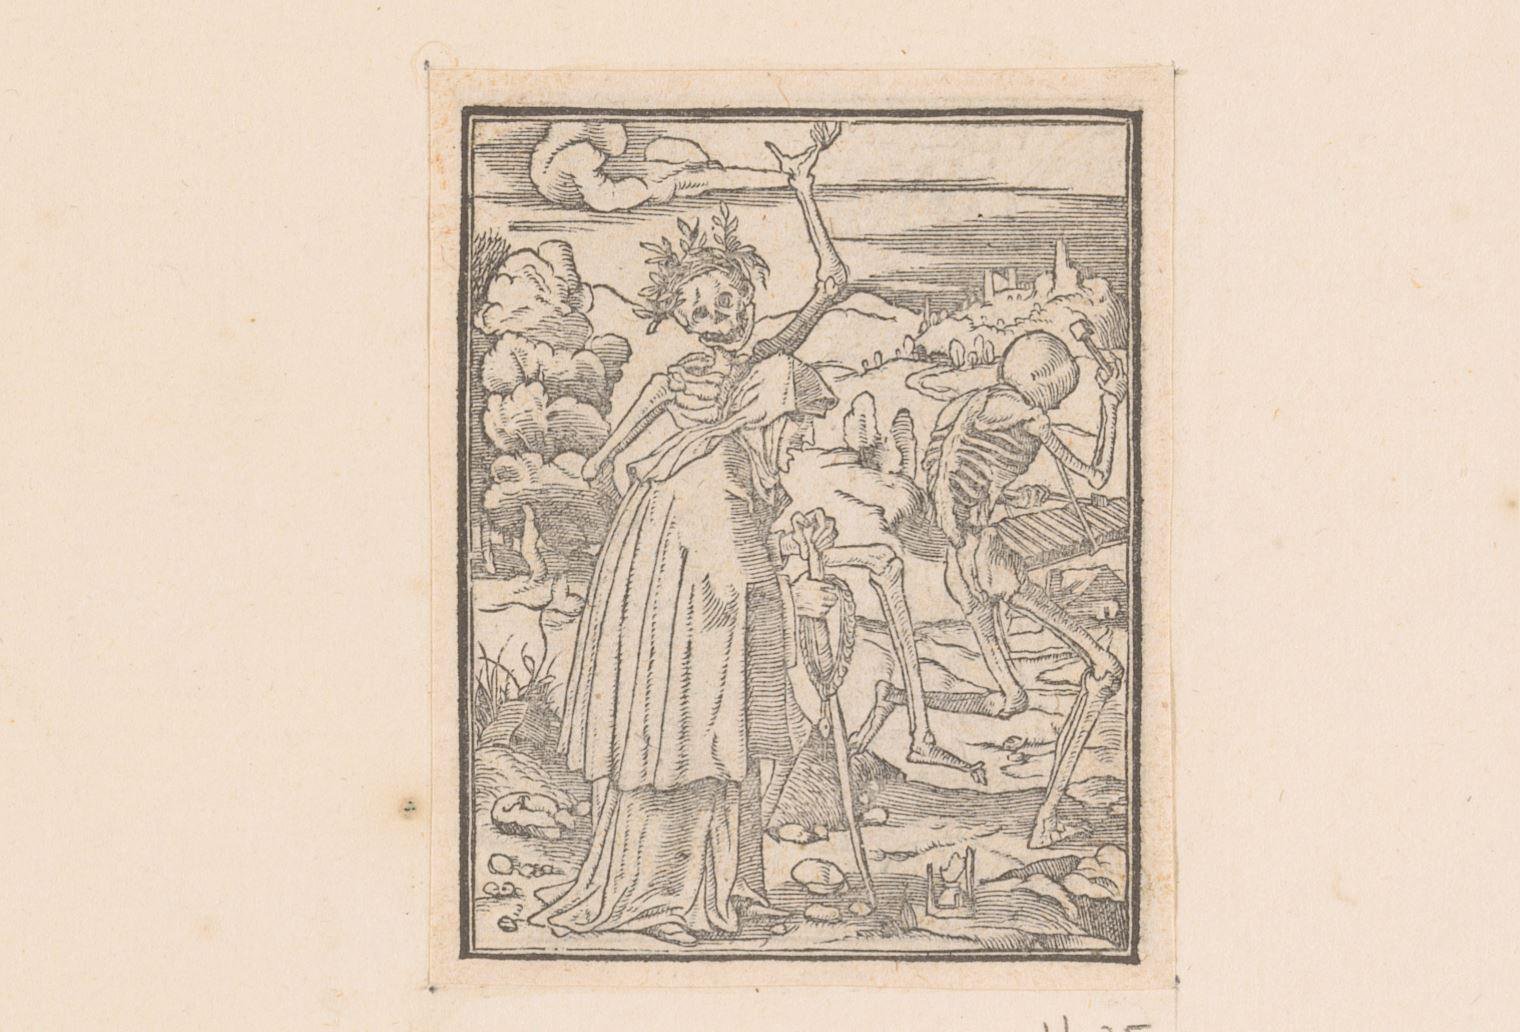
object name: print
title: Kopieën naar Holbeins Dodendans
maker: Anonymous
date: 1547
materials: paper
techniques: woodcut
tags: dance of death; death together with one or more human beings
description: Kopie van een prent van Hans Holbein de jongere uit 1538, voor het eerst gepubliceerd in: Imagines mortis (...). Lyon: Johannes Frellon, 1547.